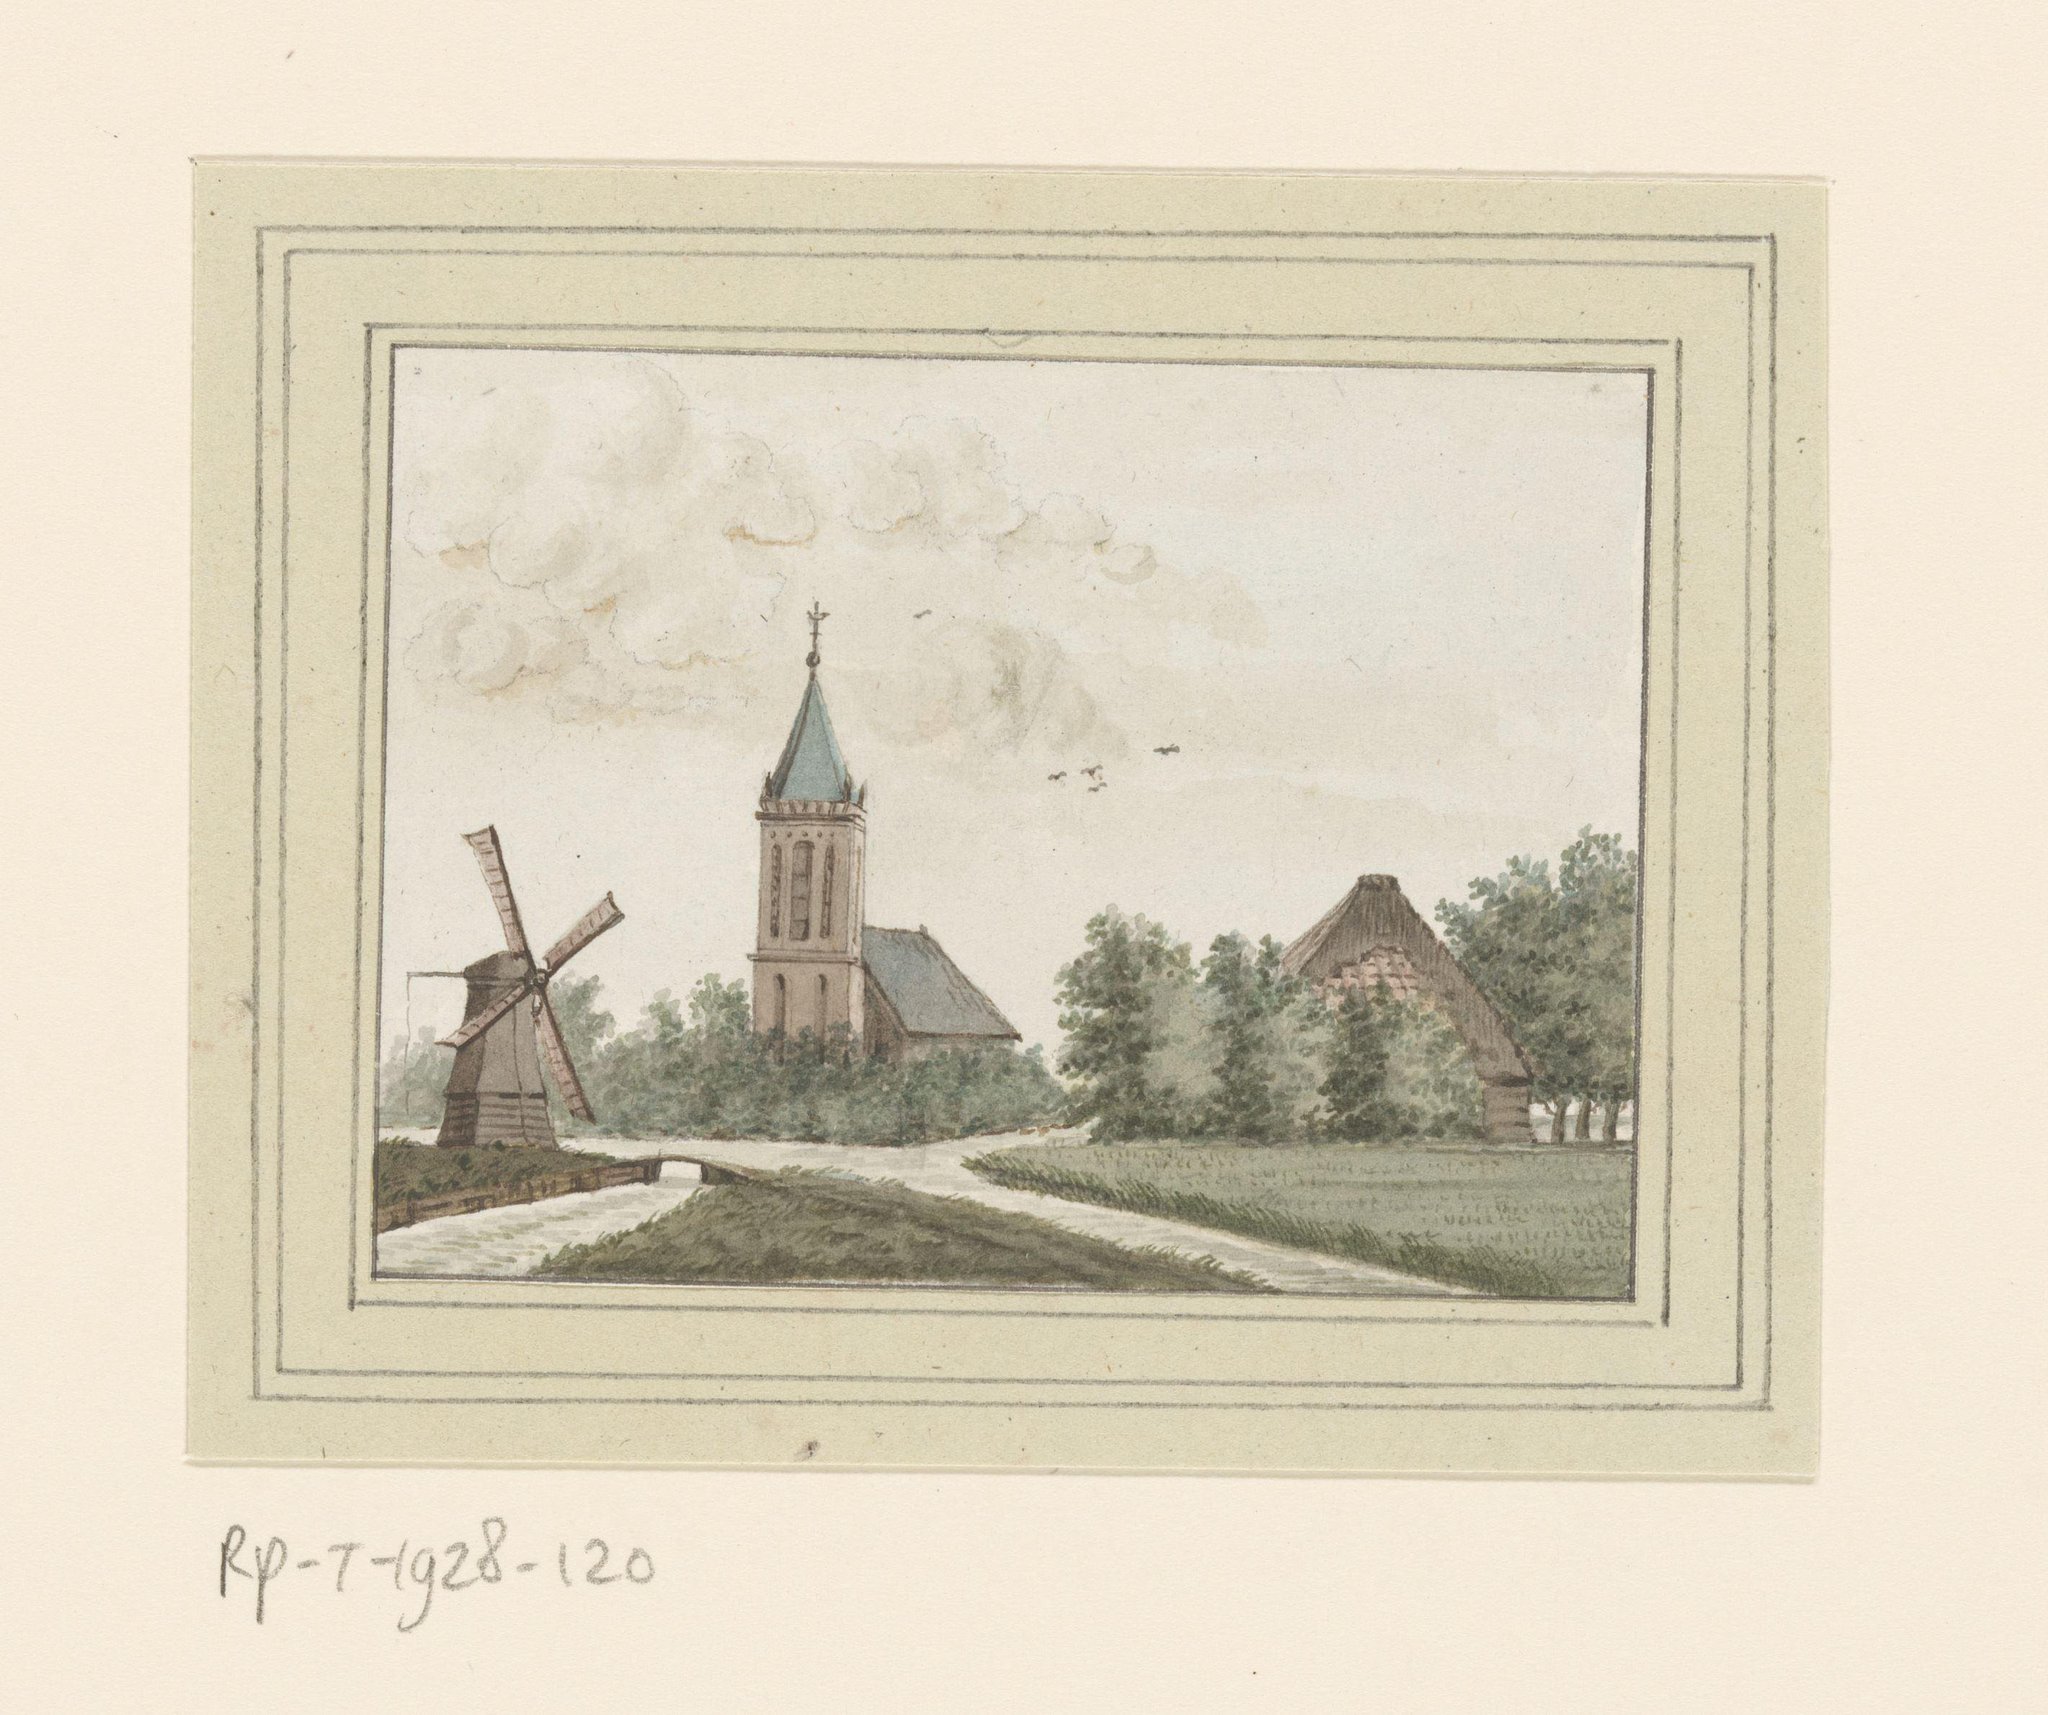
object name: drawing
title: Gezicht op het dorp Hoogwoud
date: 1752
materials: ink, paper, pencil, watercolor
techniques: brush, pen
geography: haarlem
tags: church (exterior), windmill in landscape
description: Mogelijk een kopie naar de prent van Hendrik Spilman, zie RP-P-2019-510.